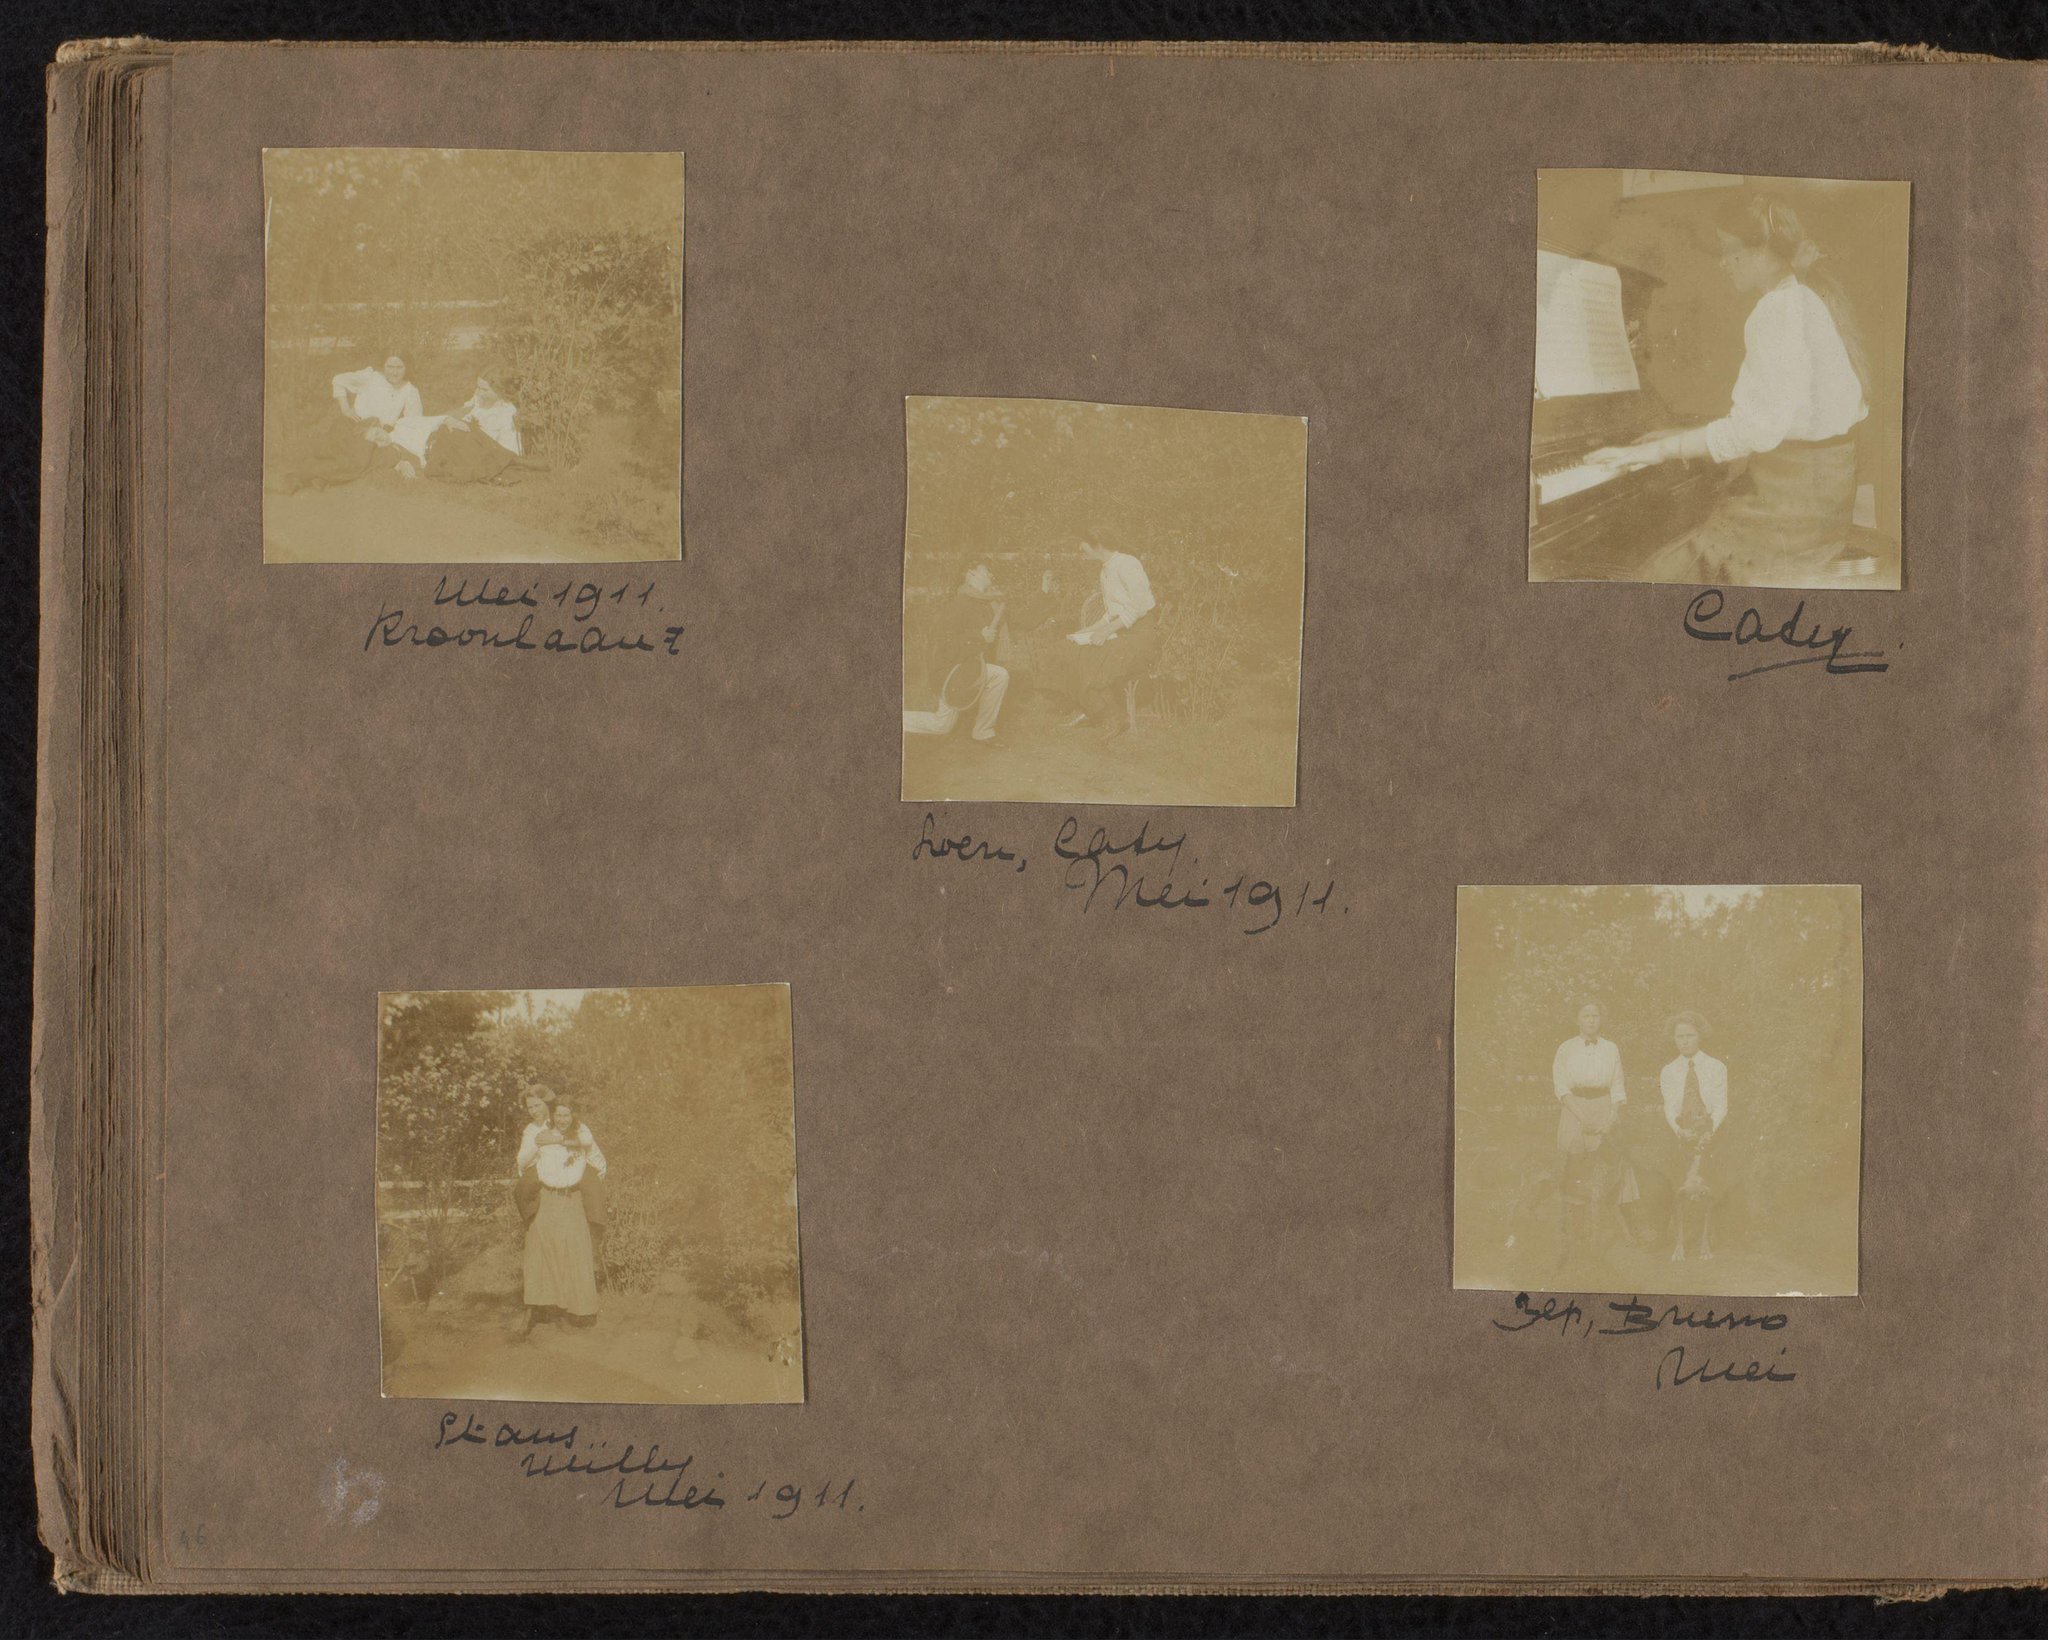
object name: photograph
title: Vijf foto's van Loentje Onnen met vriendinnen, onder andere Caty van den Wall Bake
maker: carolina frederika onnen (lien/loen)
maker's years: 1896-1983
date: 1905-1911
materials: paper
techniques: gelatin silver print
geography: hilversum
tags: amsterdam, carolina frederika onnen (lien/loen), historical persons - bb - woman, friends, dog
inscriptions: inscription: ‘Zep, Bruno/ Mei’, inscription: ‘Caty’, inscription: ‘Mei 1911/ Kroonlaan 7’, inscription: ‘Loen, Caty/ Mei 1911’, inscription: ‘Stans/ Willy/ Mei 1911’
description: Deze foto's maken deel uit van een album.